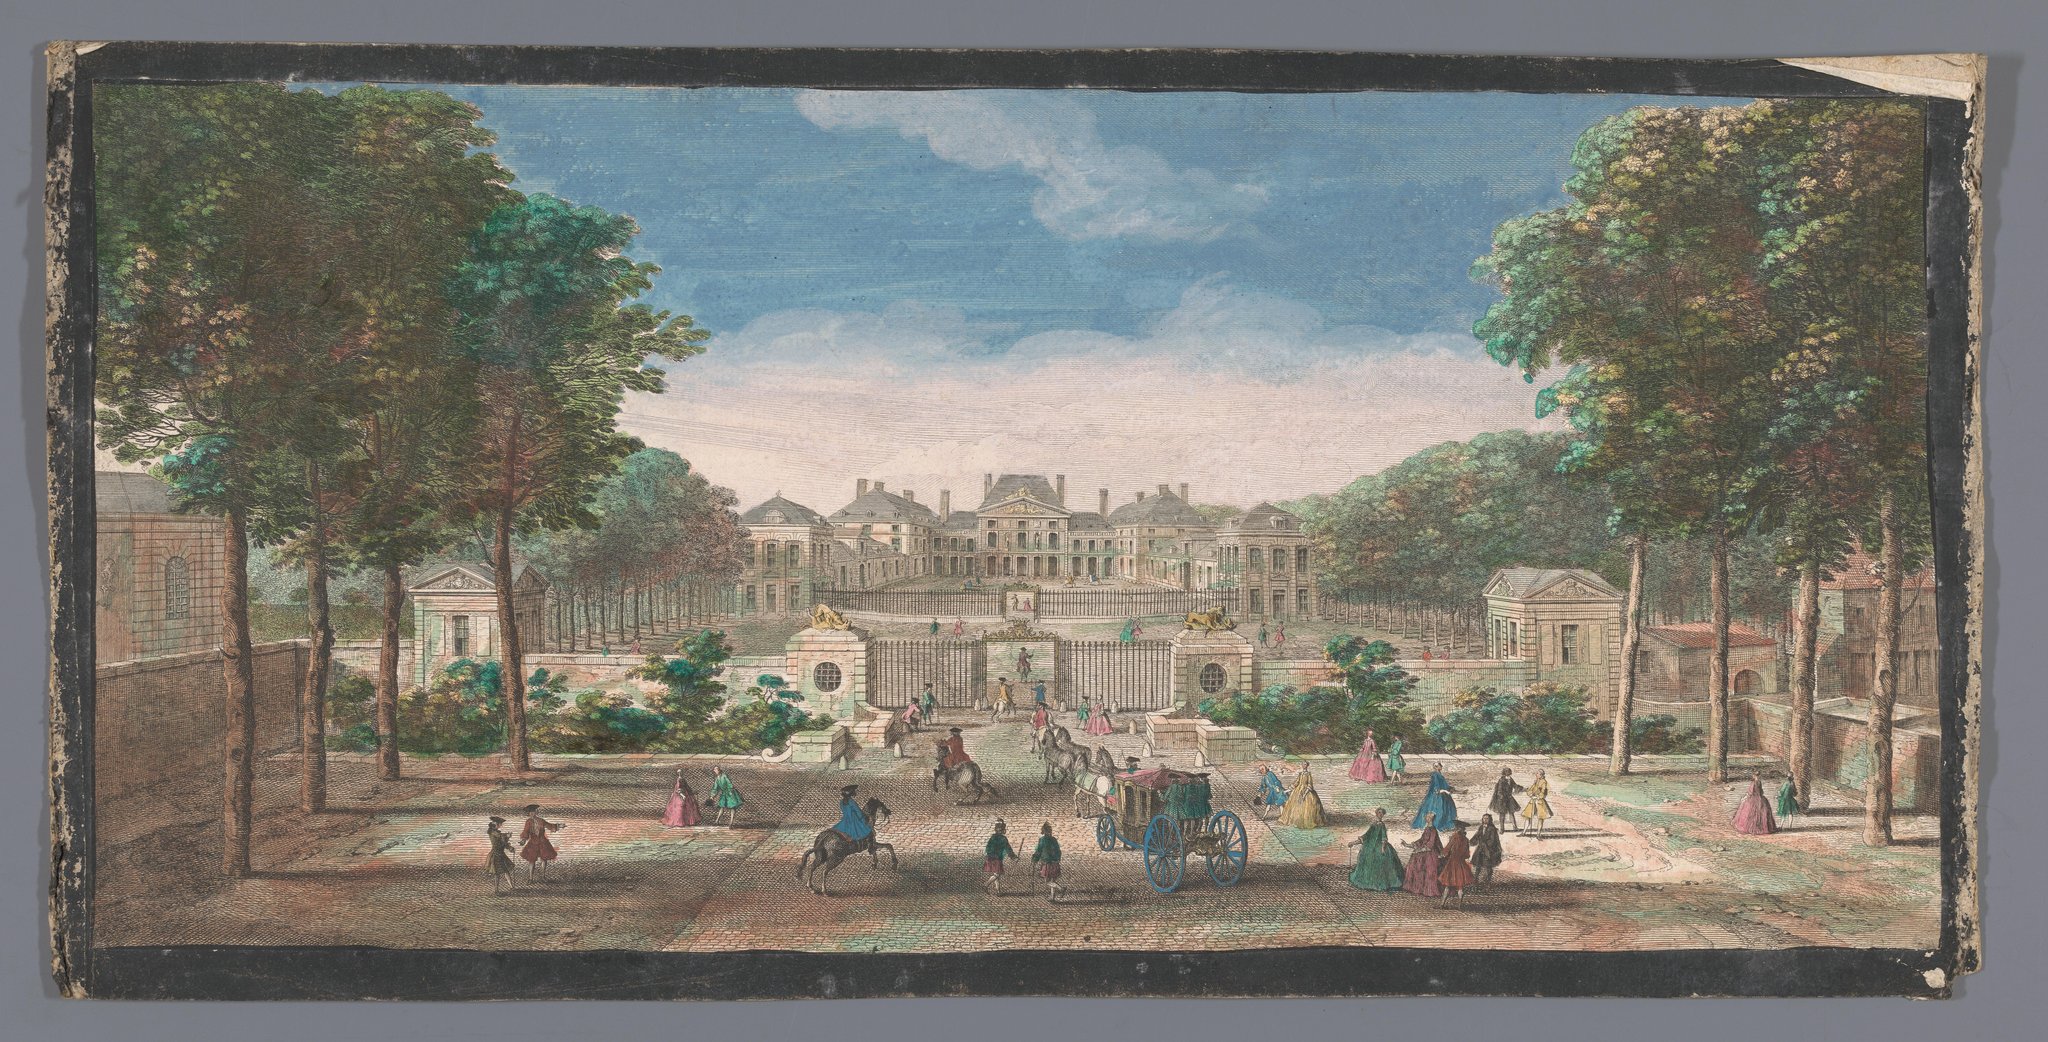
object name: print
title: Gezicht op de voorzijde van het Château de Sceaux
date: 1700-1799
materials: cardboard, paper, watercolor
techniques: brush, etching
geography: paris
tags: civic architecture; edifices; dwellings